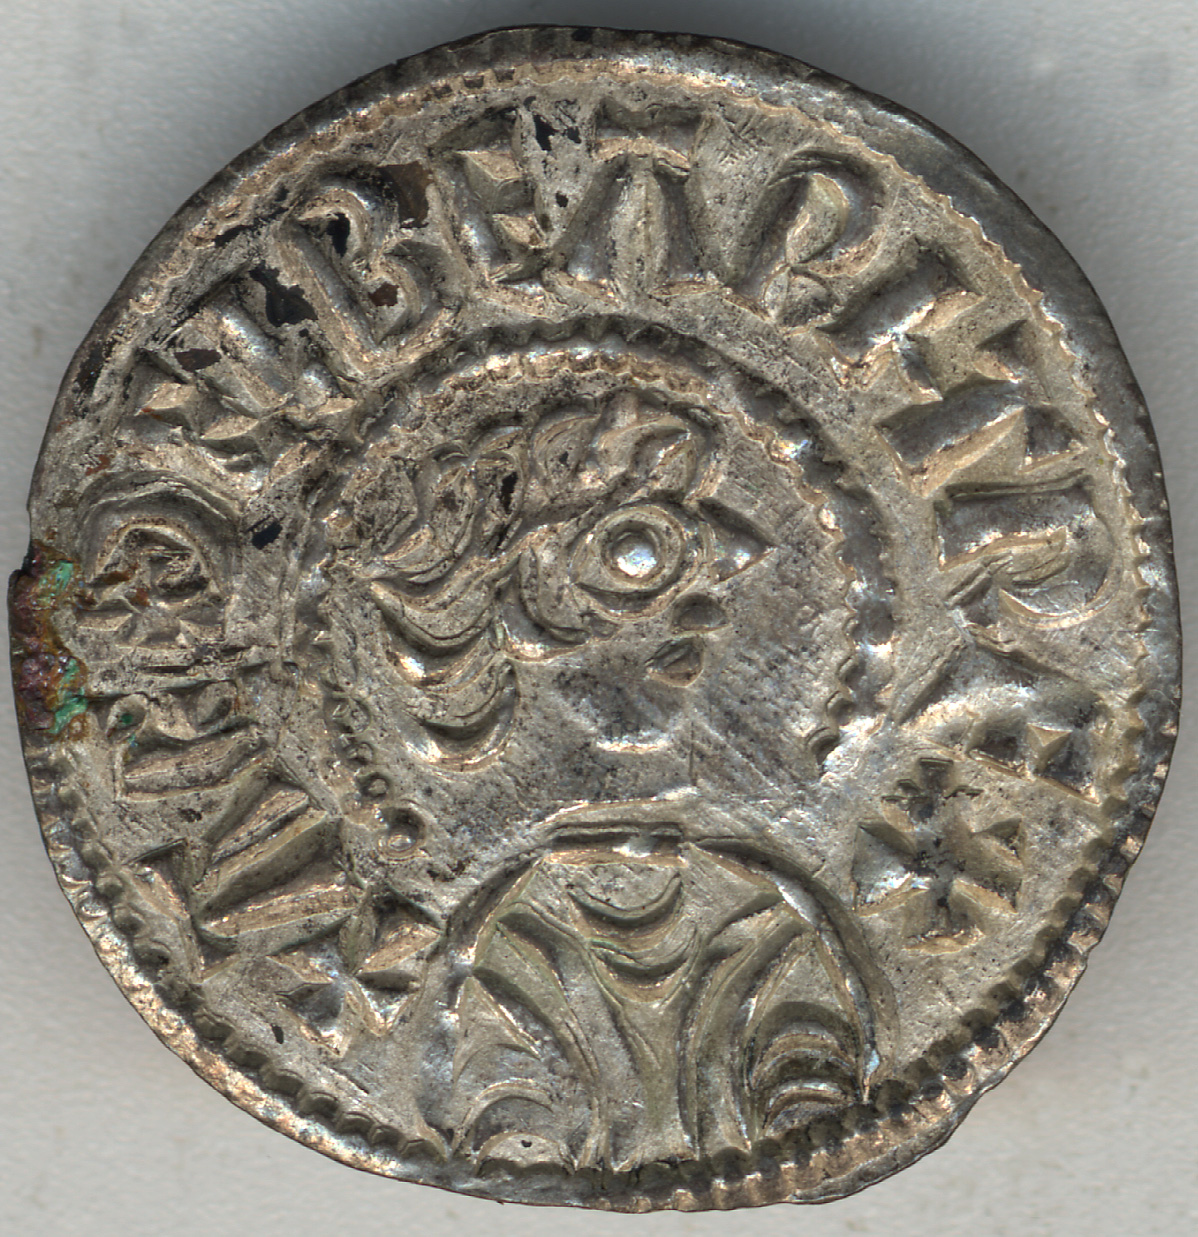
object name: coin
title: Wessex Penny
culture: british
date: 861-866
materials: silver